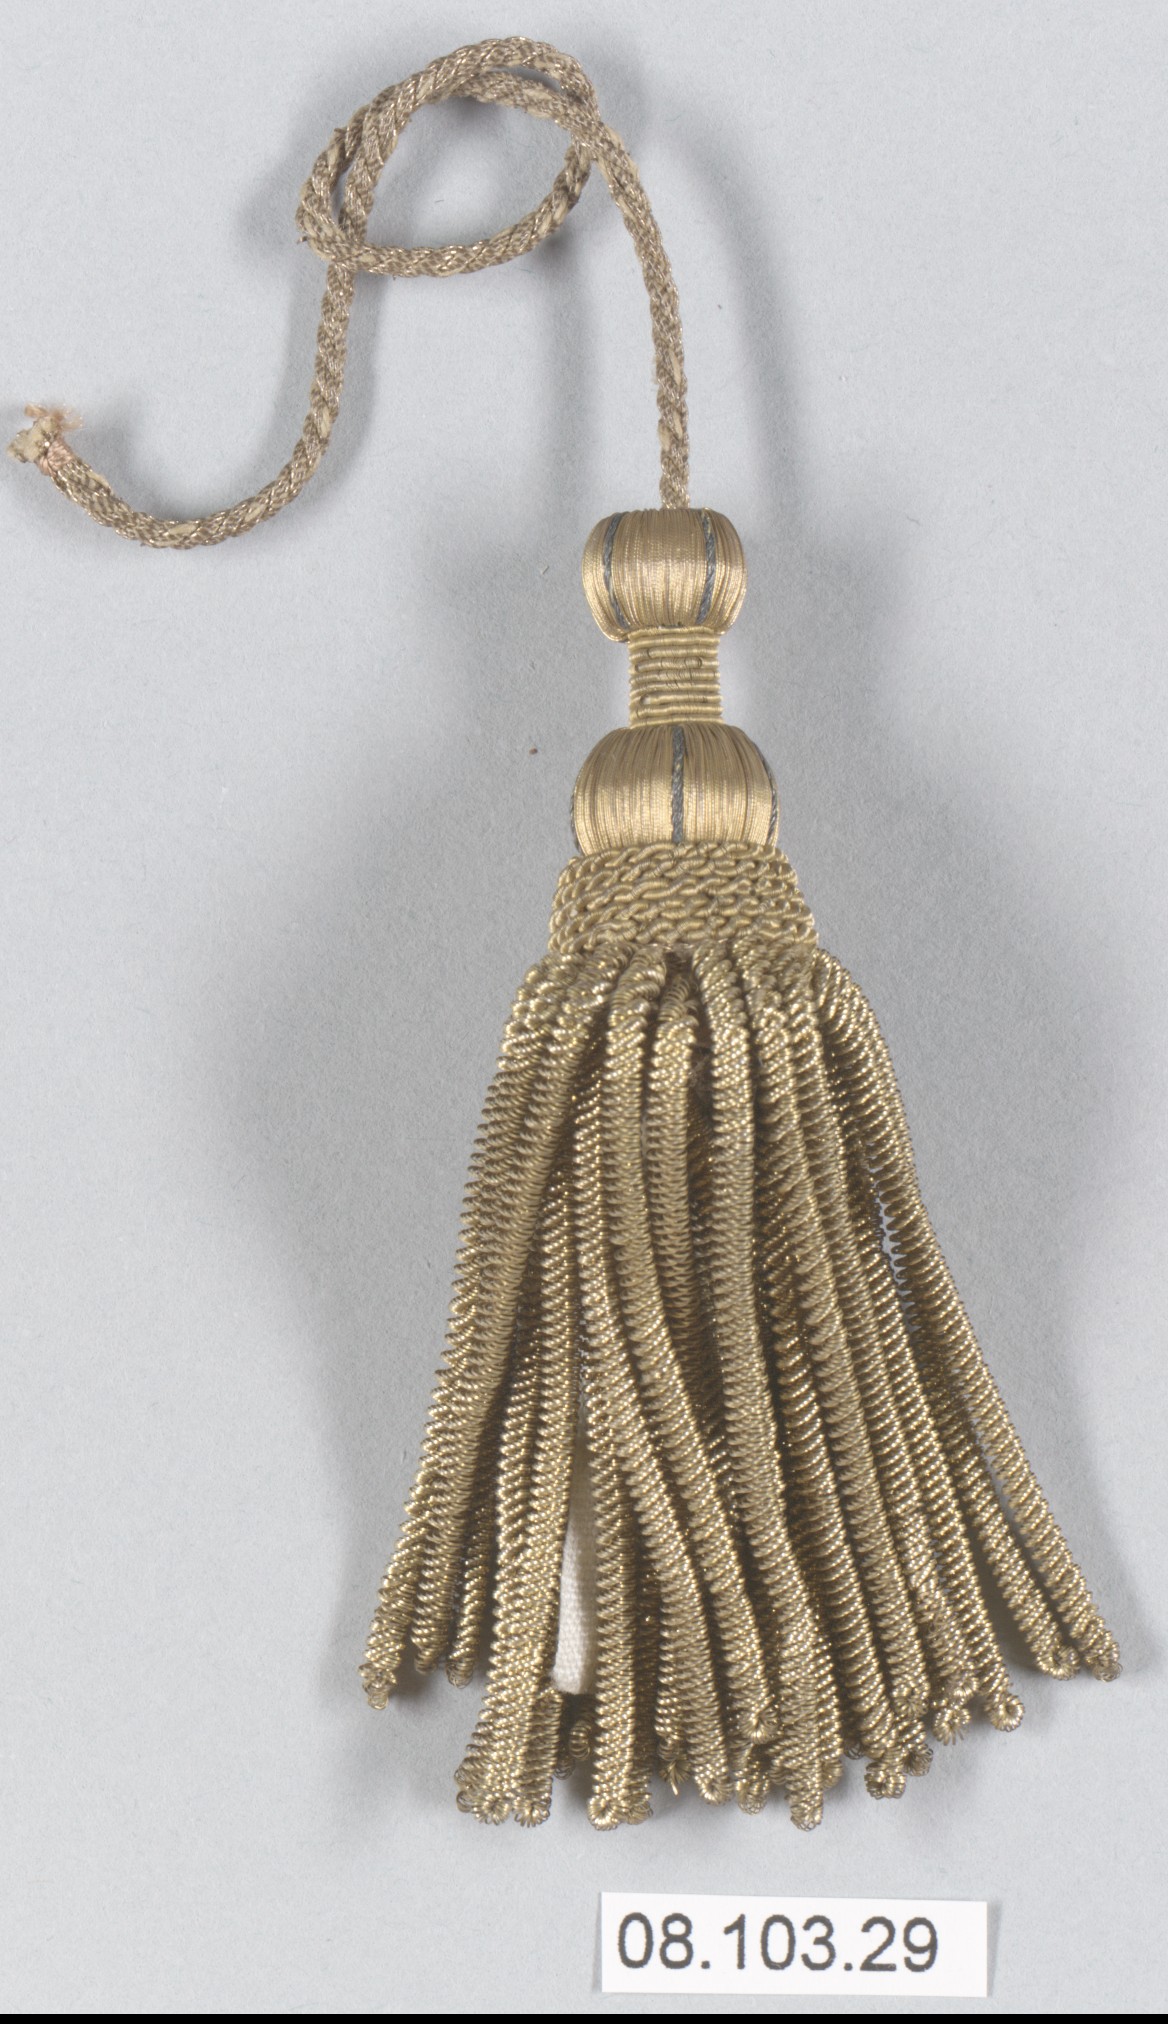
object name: tassel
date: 1701-1900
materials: metal thread